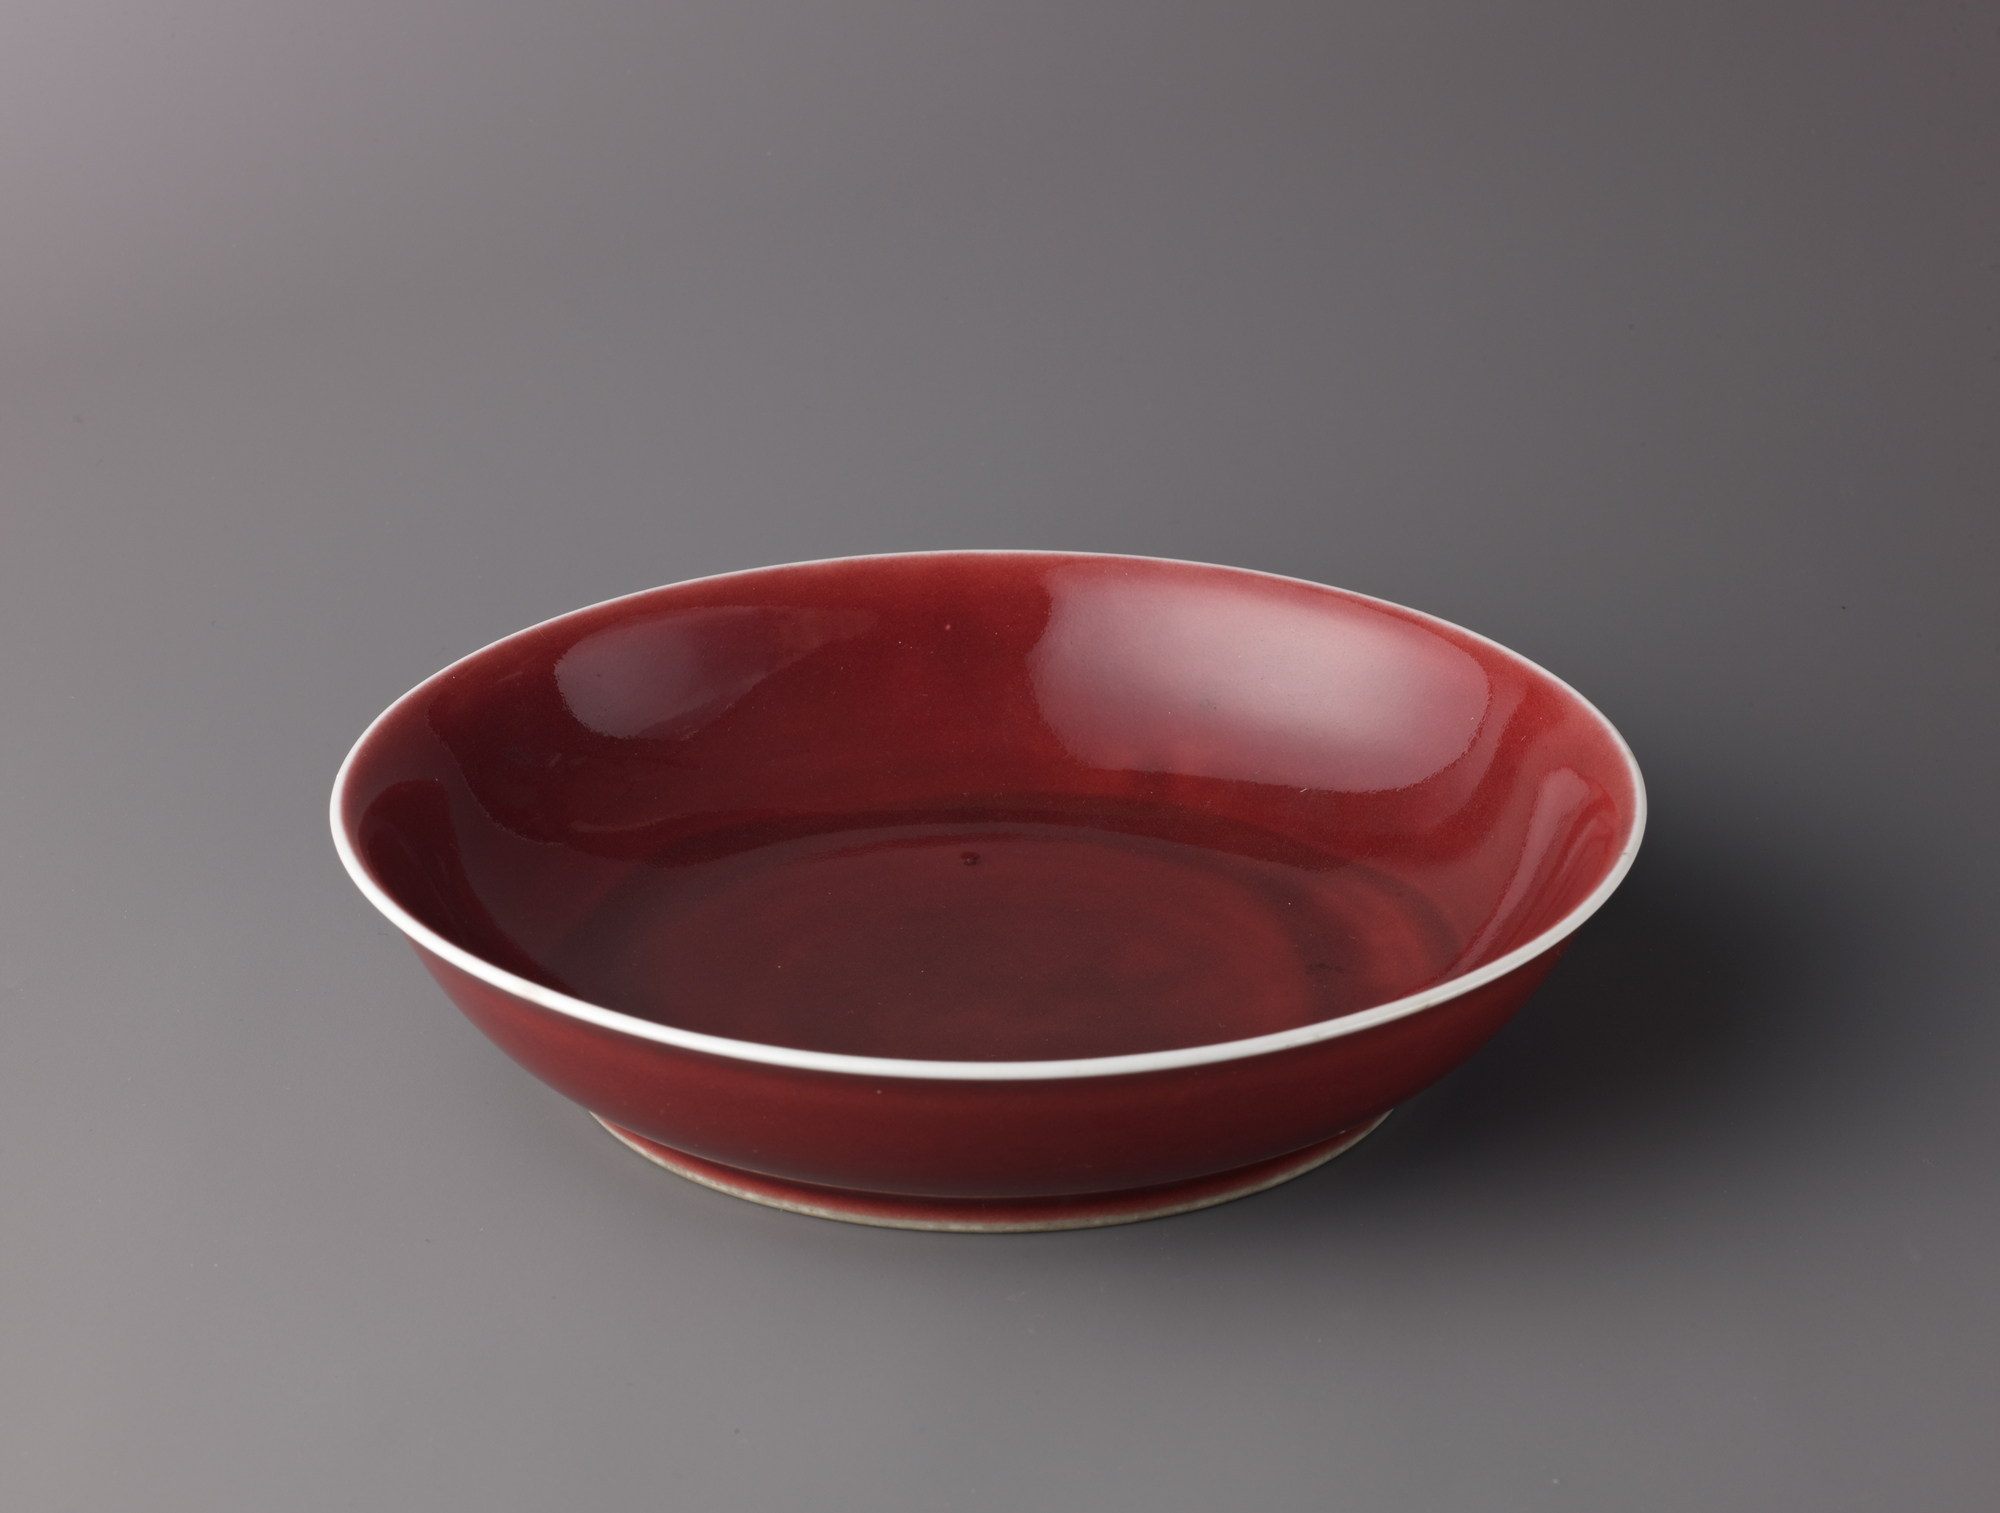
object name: dish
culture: chinese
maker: chinese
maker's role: artist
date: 1821-1850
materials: glaze, porcelain